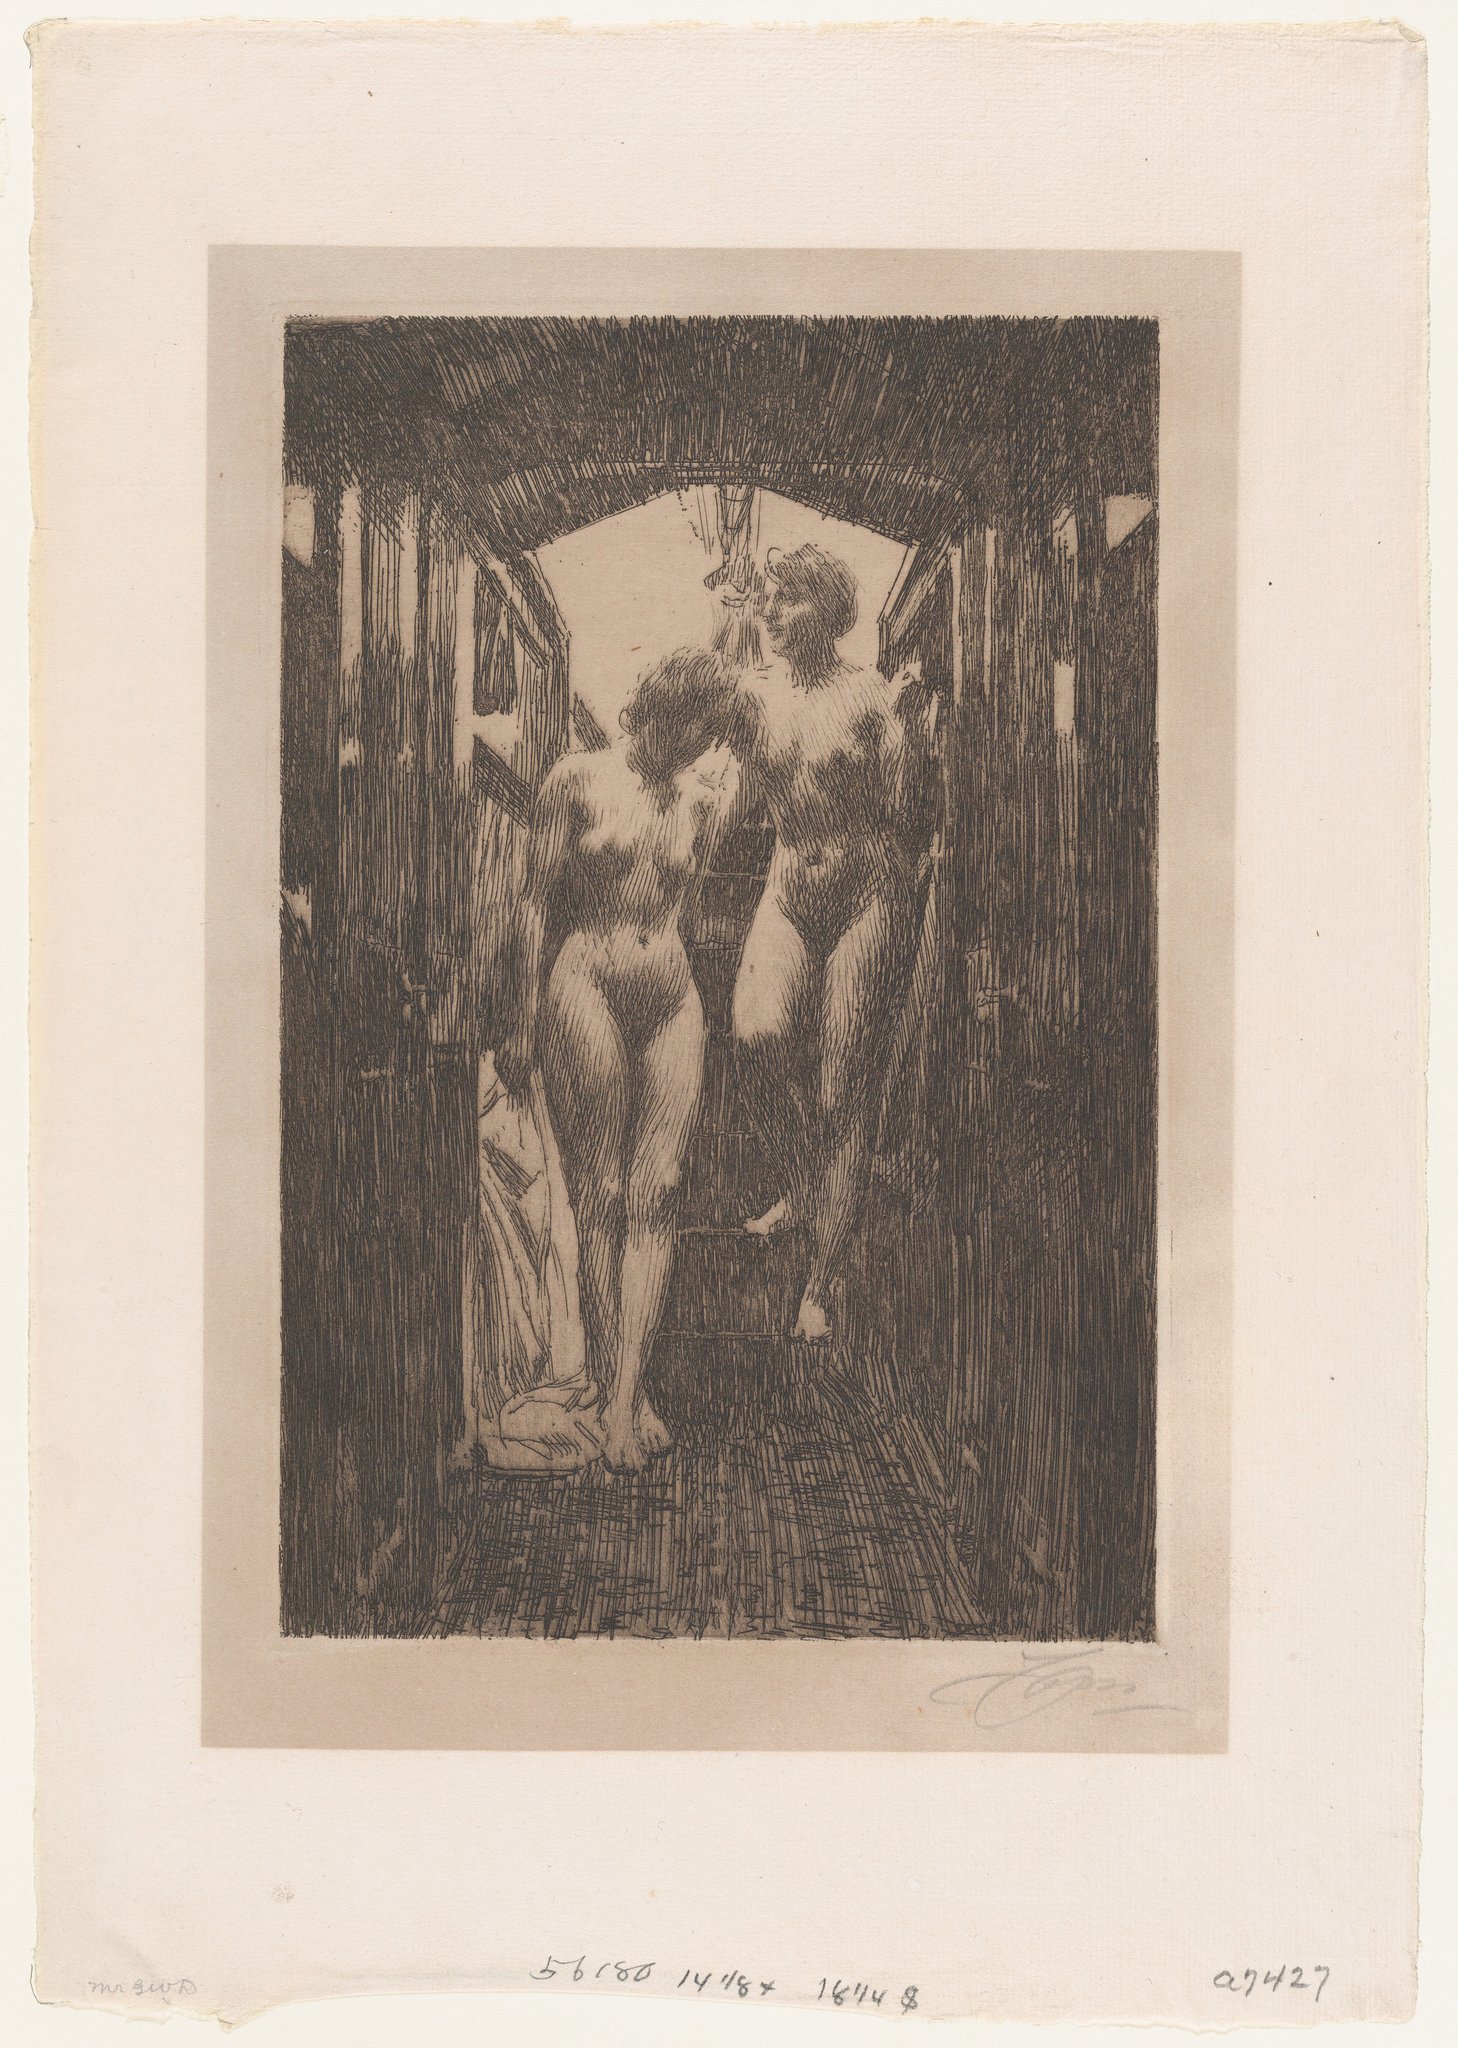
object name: print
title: Cabin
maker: anders zorn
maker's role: artist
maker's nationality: swedish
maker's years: 1860-1920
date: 1917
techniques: etching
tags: female nudes